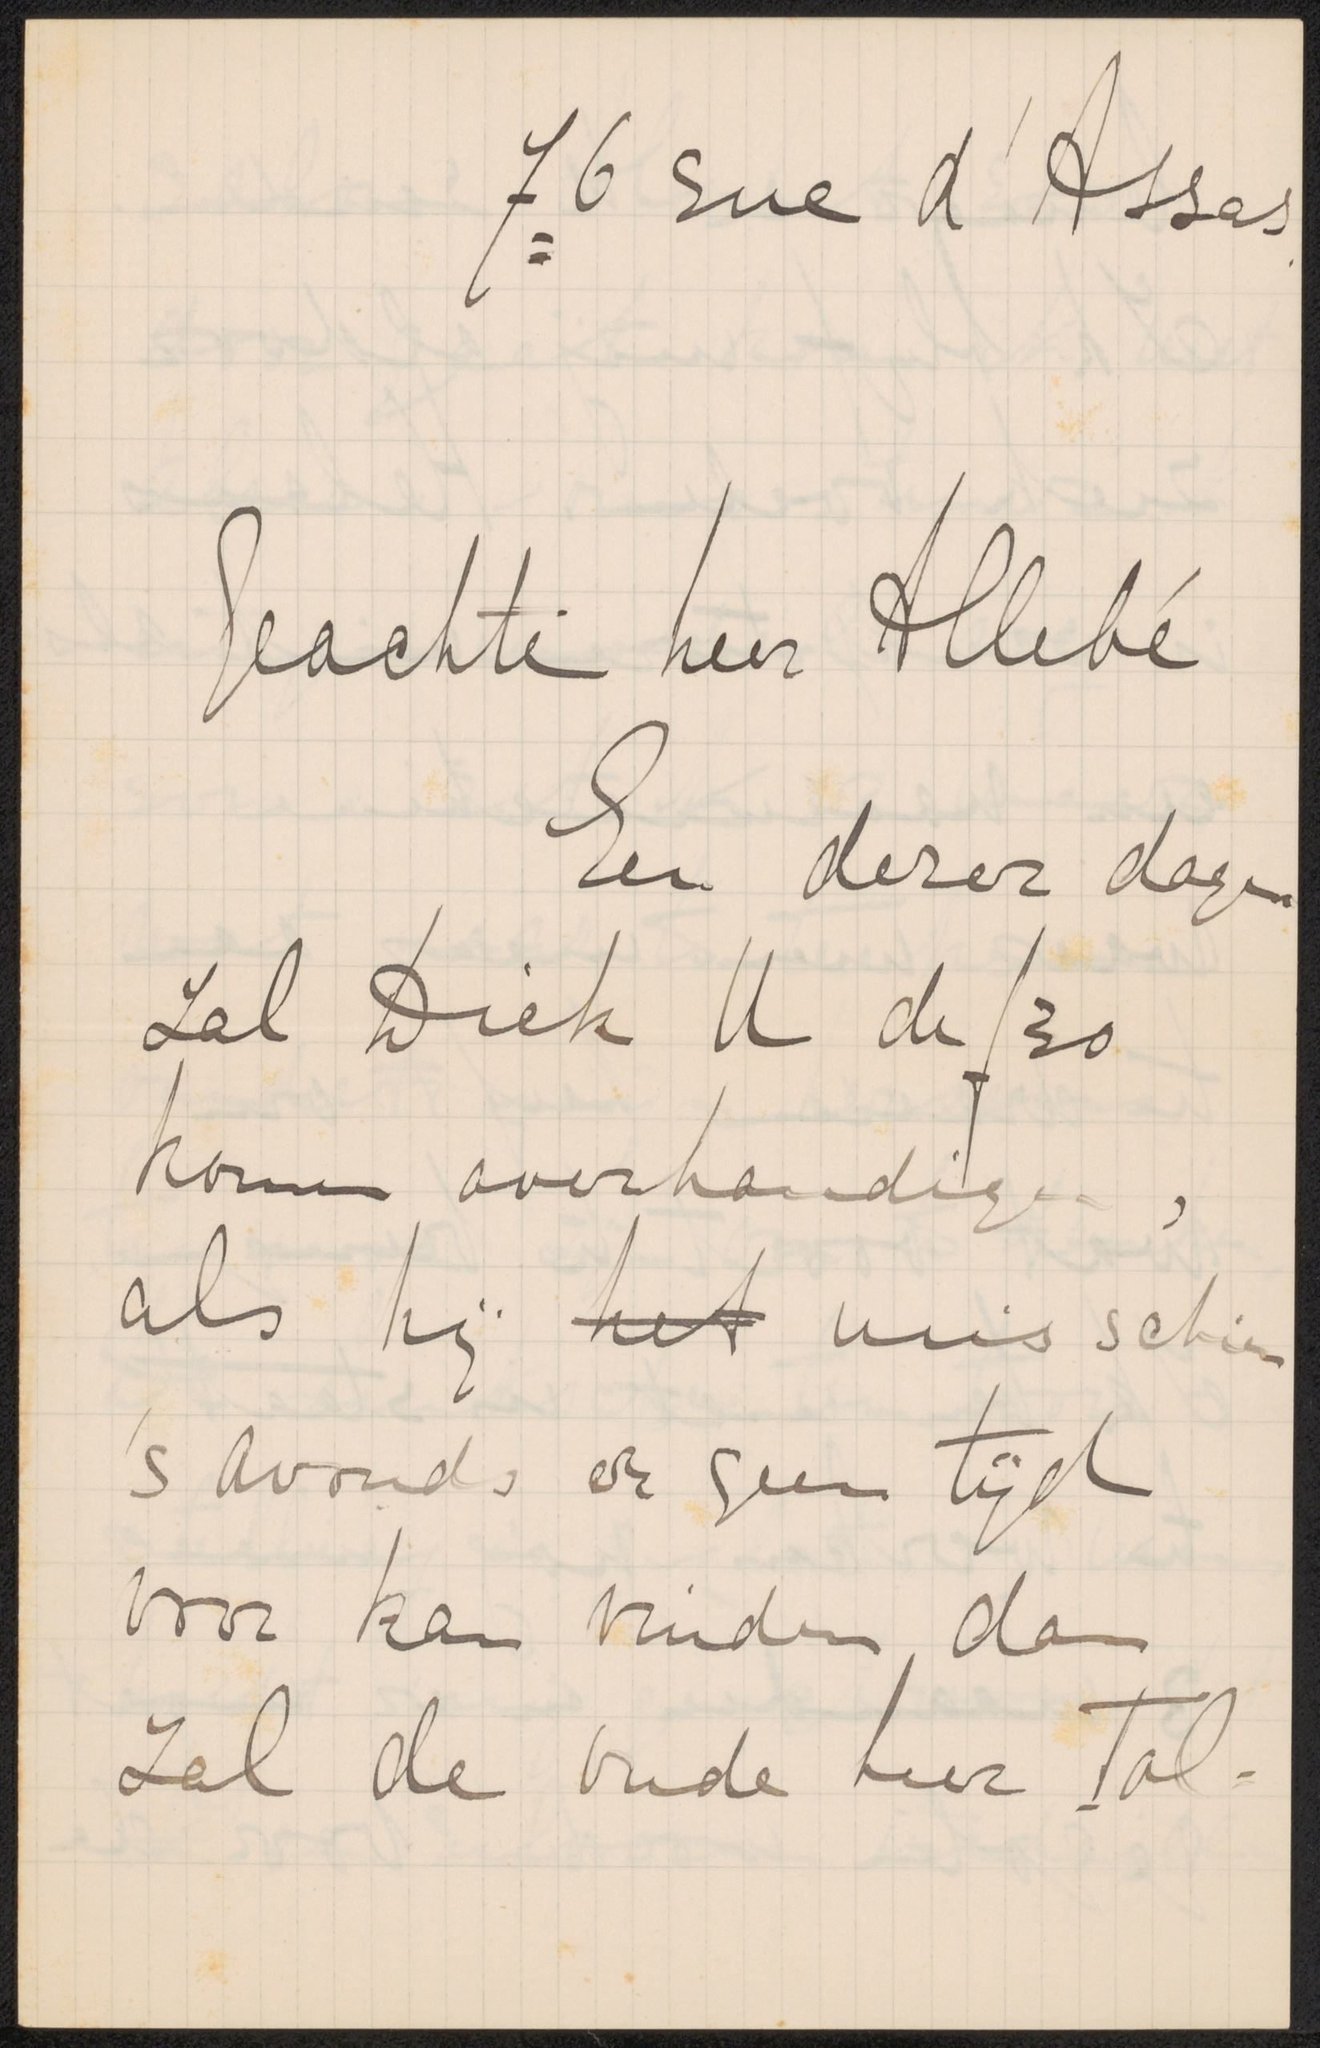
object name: letter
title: Brief aan August Allebé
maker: annie ermeling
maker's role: draughtsman, print maker, sculptor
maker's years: 1865-1932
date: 1875-1927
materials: ink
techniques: pen, writing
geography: paris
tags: print maker, draughtsman, august allebé, artist's model, sitter, sculpture, exhibition ~ art, diseases, money